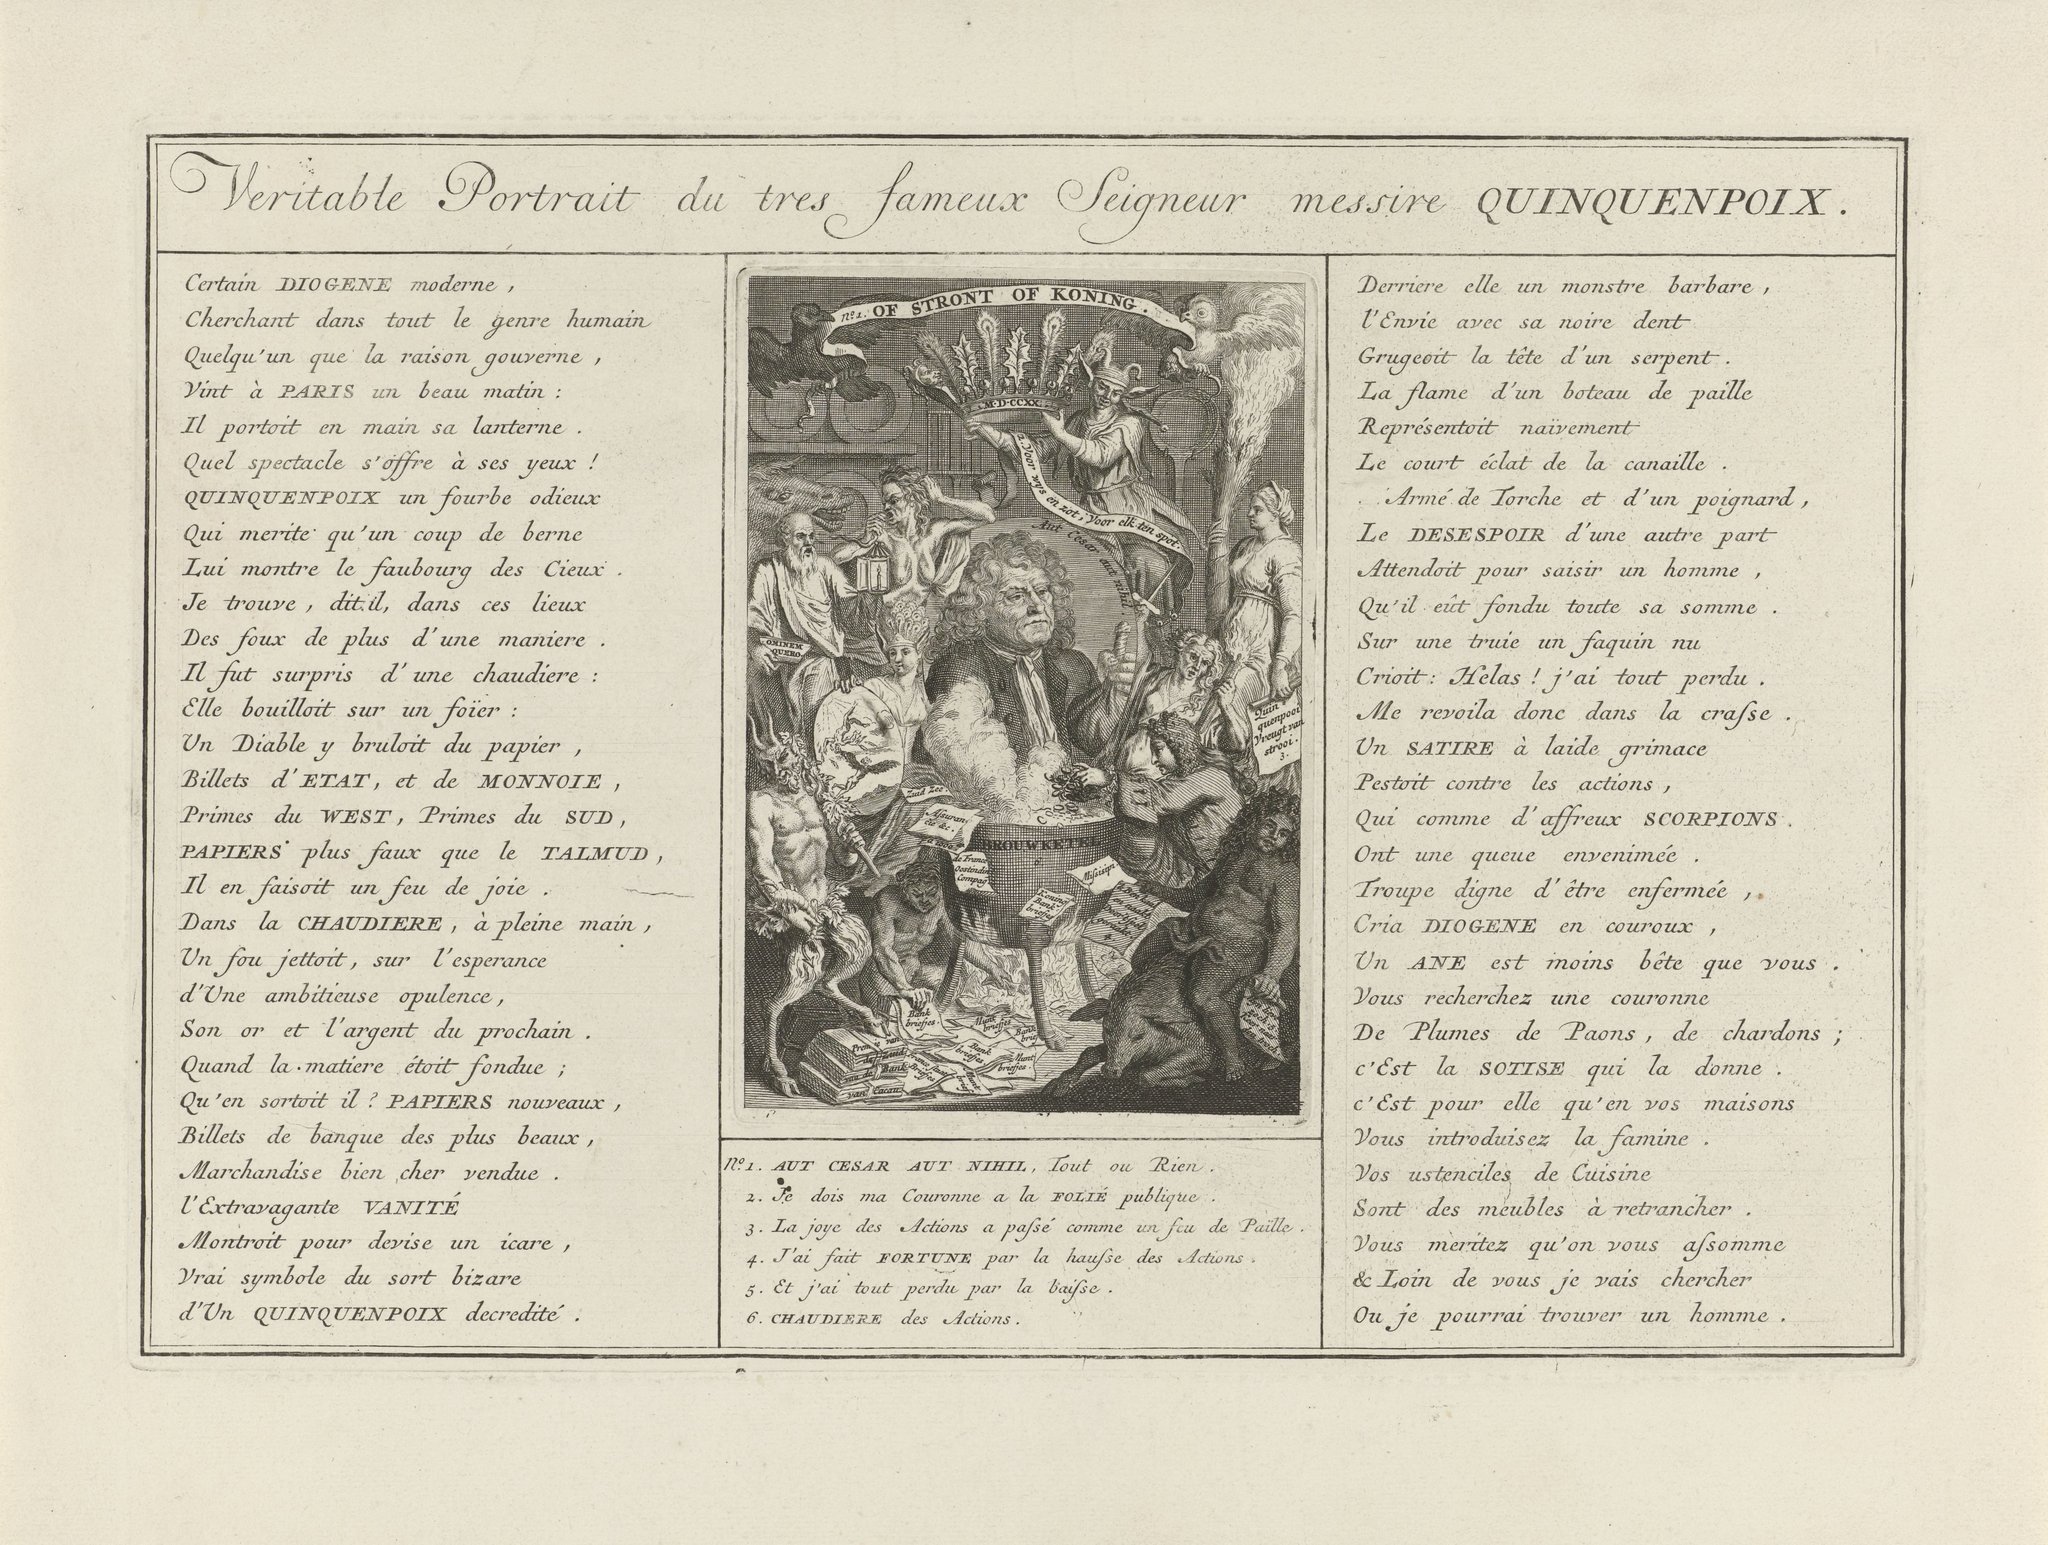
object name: print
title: Veritable Portrait du tres fameux Seigneur messire Quinquenpoix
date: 1712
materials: paper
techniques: engraving, etching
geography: amsterdam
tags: dealing in money (+ variant), brewing, boiling (in a cauldron); witches' kitchen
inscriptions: collector's mark: Lugt 2228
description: Ware afbeelding van de heer Quinquempoix. Portretmedaillon van John Law als de heer Quinquempoix boven een brouwketel waarin geldstukken worden omgetoverd tot aandelen. Heksenketel met duivels, uilen en andere wezens. Boven het portret de Zotheid met een kroon van pauwenveren en hulstbladeren. Hierboven een banderol met: No. 1 Of Stront of Koning. Deze plaat afgedrukt binnen een grotere plaat met titel en verzen in het Frans aan weerszijden. Prent 37 in de serie Het Groote Tafereel der Dwaasheid met spotprenten op de Windhandel of Actiehandel van 1720.